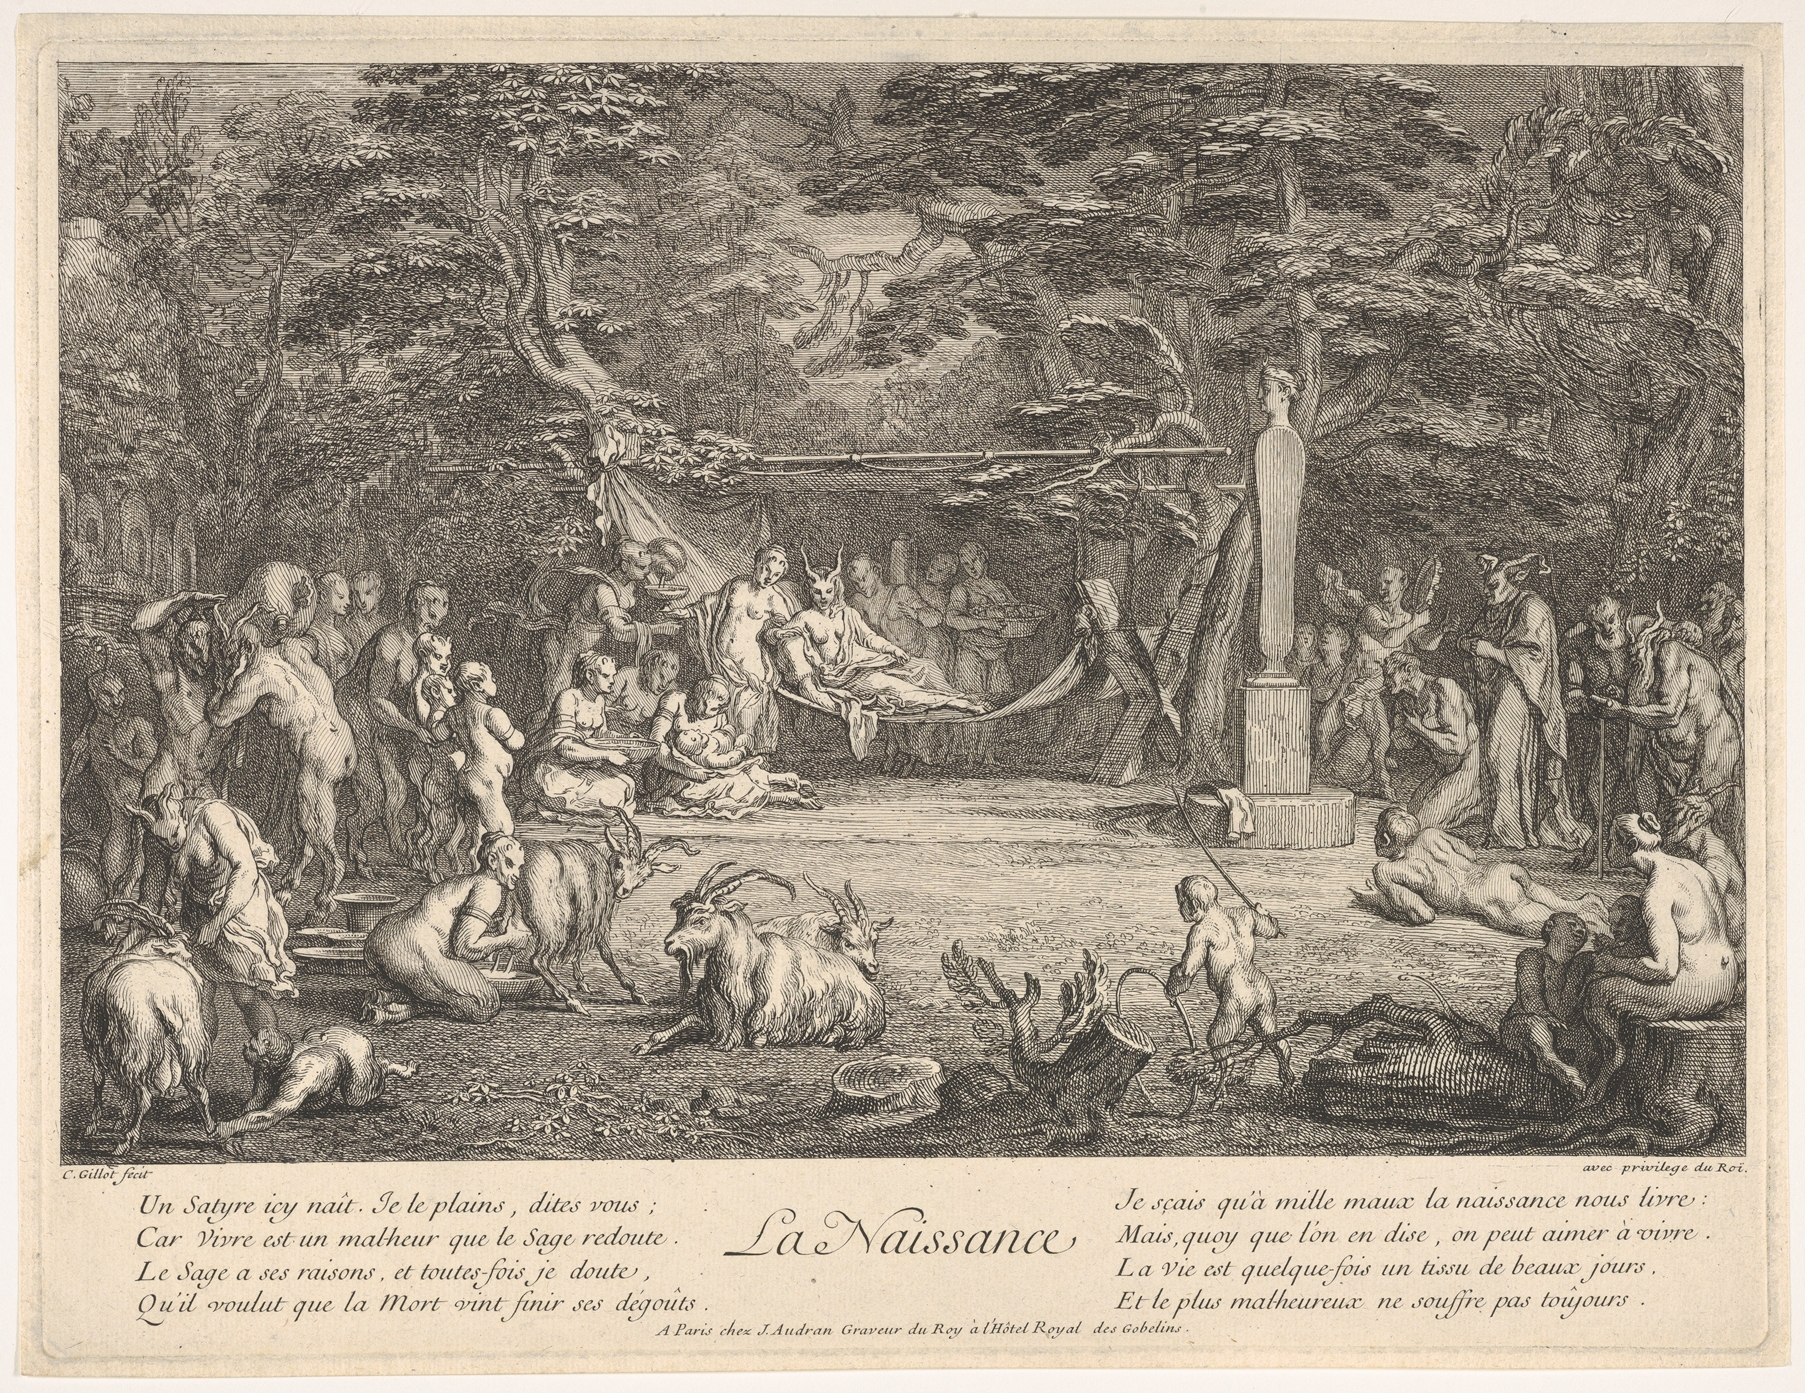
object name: print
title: The Birth (La Naissance): in a forest, the new mother resting in a hammock at center, the newborn below her to left, various satyrs and goats surrounding, from "The lives of satyrs" (La vie des satyres)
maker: claude gillot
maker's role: artist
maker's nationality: french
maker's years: 1673-1722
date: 1700-1720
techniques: etching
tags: satyrs,goats,forests,birth,crowd